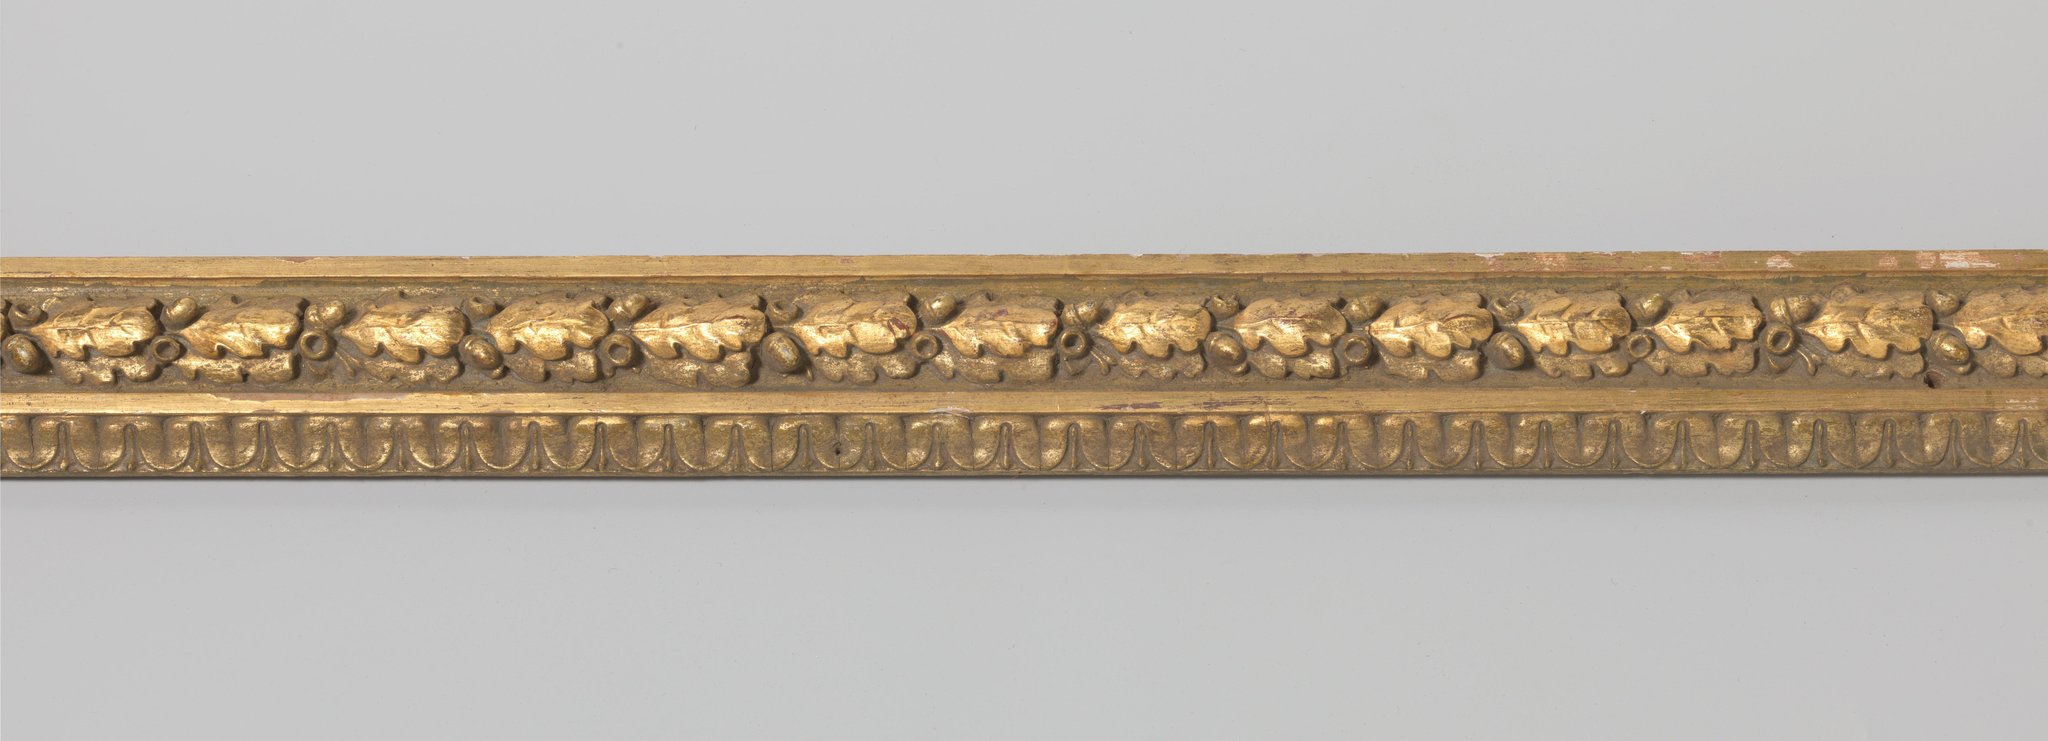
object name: frame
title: Lijstfragment: vergulde lijst met pâte-ornamenten, rechterstijl.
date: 1700-1899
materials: gold leaf, wood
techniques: gilding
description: Vergulde lijst met eikenbladeren met eikeltjes. Lijstdeel, rechter stijl. Met achterop geschreven: 'Right side, no. 4'.